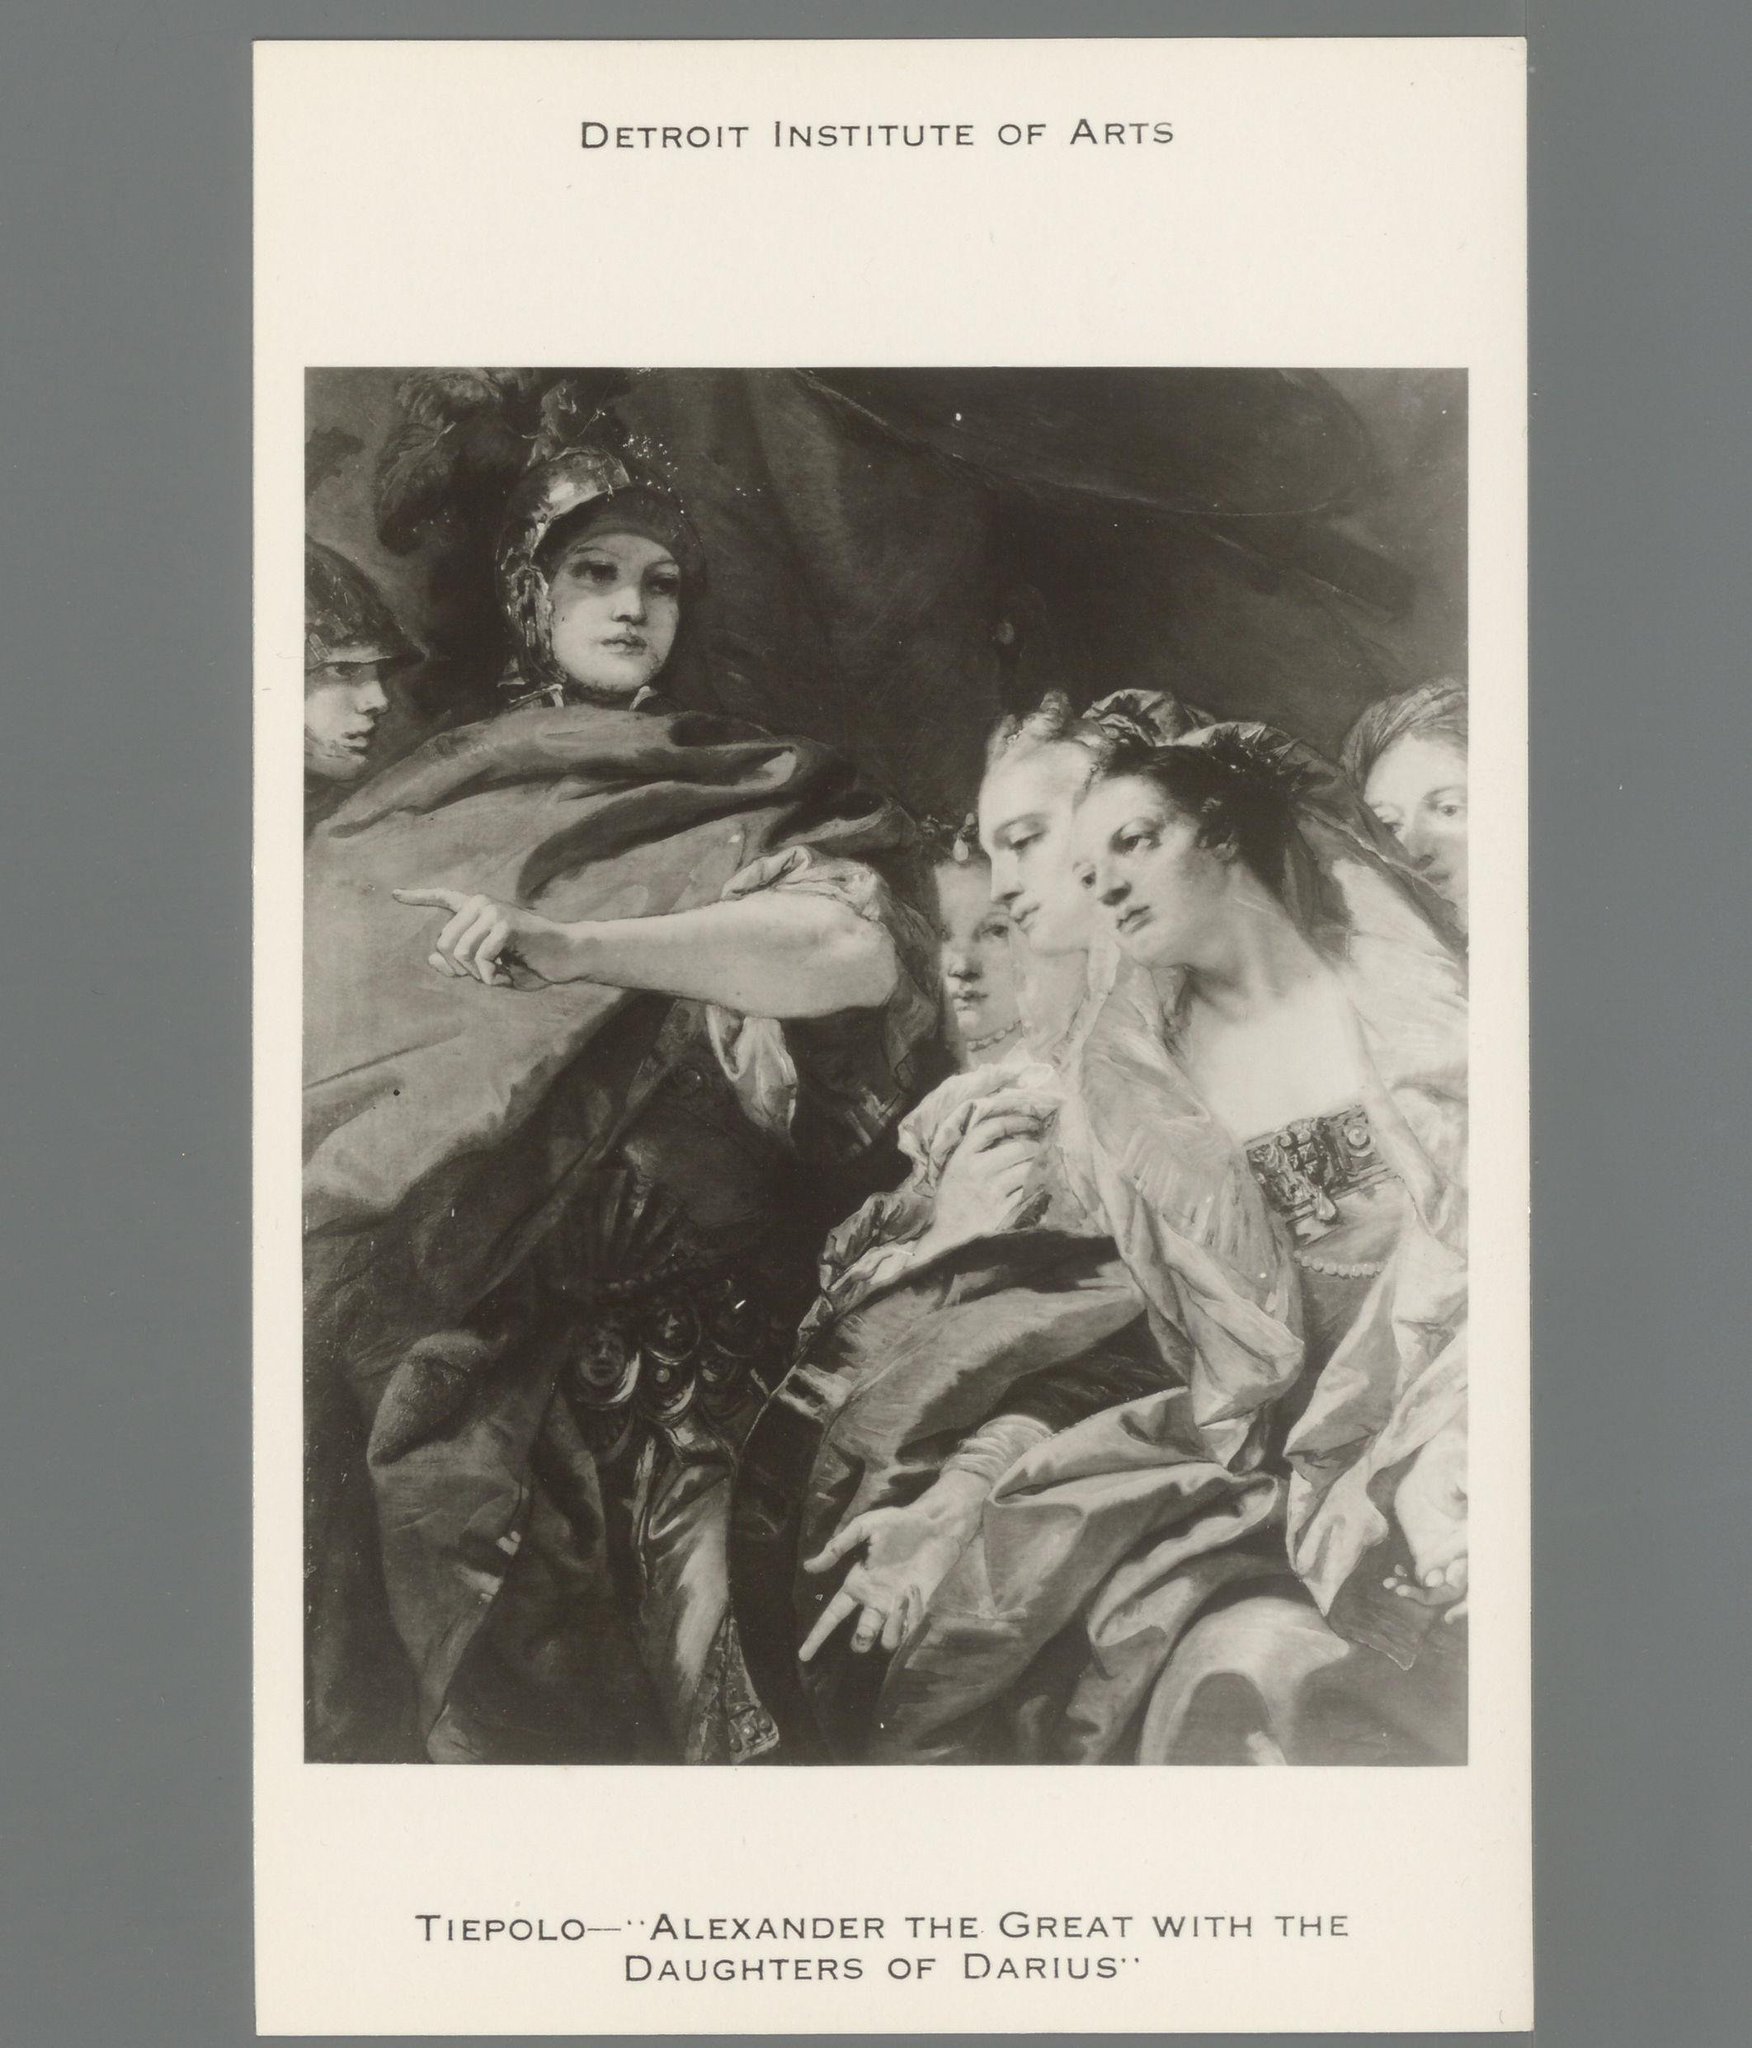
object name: reproduction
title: Alexander The Great With the Daughters of Darius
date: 1927-1945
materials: photographic support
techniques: photography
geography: detroit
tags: helmet, adult woman (+ five persons)